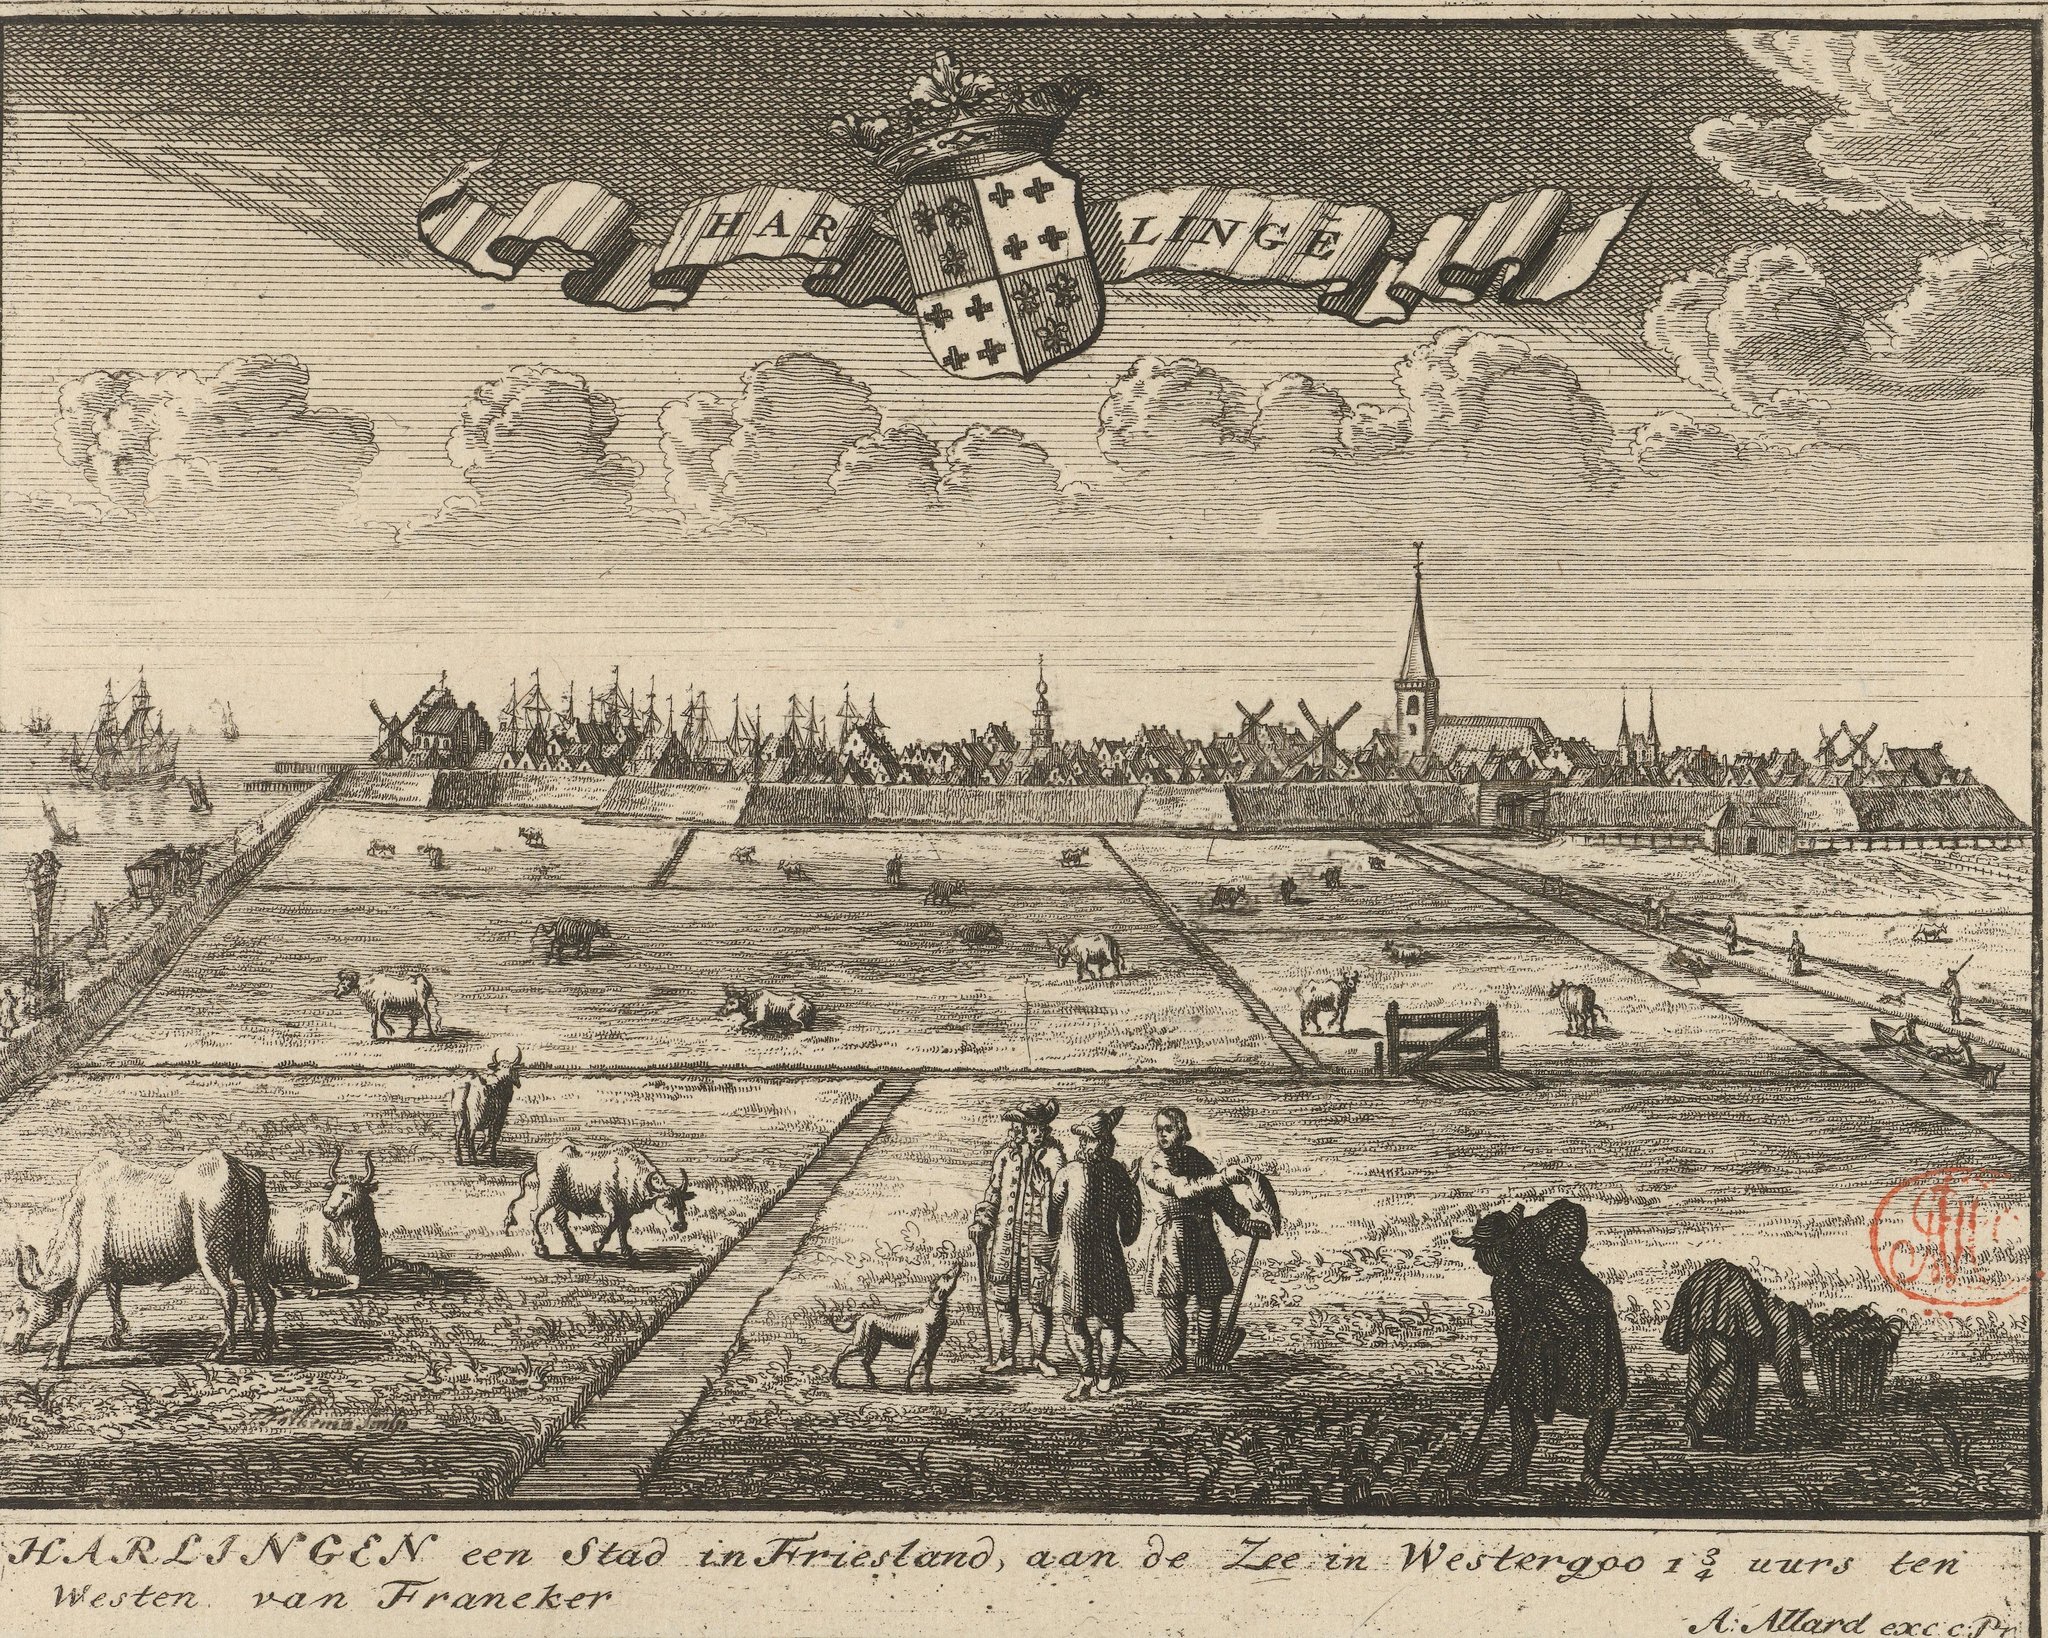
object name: print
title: Stadsgezichten uit Friesland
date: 1702-1725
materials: paper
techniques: etching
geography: amsterdam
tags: city-view, and landscape with man-made constructions, harlingen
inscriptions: collector's mark: Lugt 195, collector's mark: Lugt 2228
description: Gezicht op de stad Harlingen waarboven een banderol met de naam en het wapen van de stad prijkt. In de marge staan twee regels tekst in het Nederlands. Deze ongenummerde prent maakt deel uit van een serie prenten met stadsgezichten op diverse steden in Friesland.